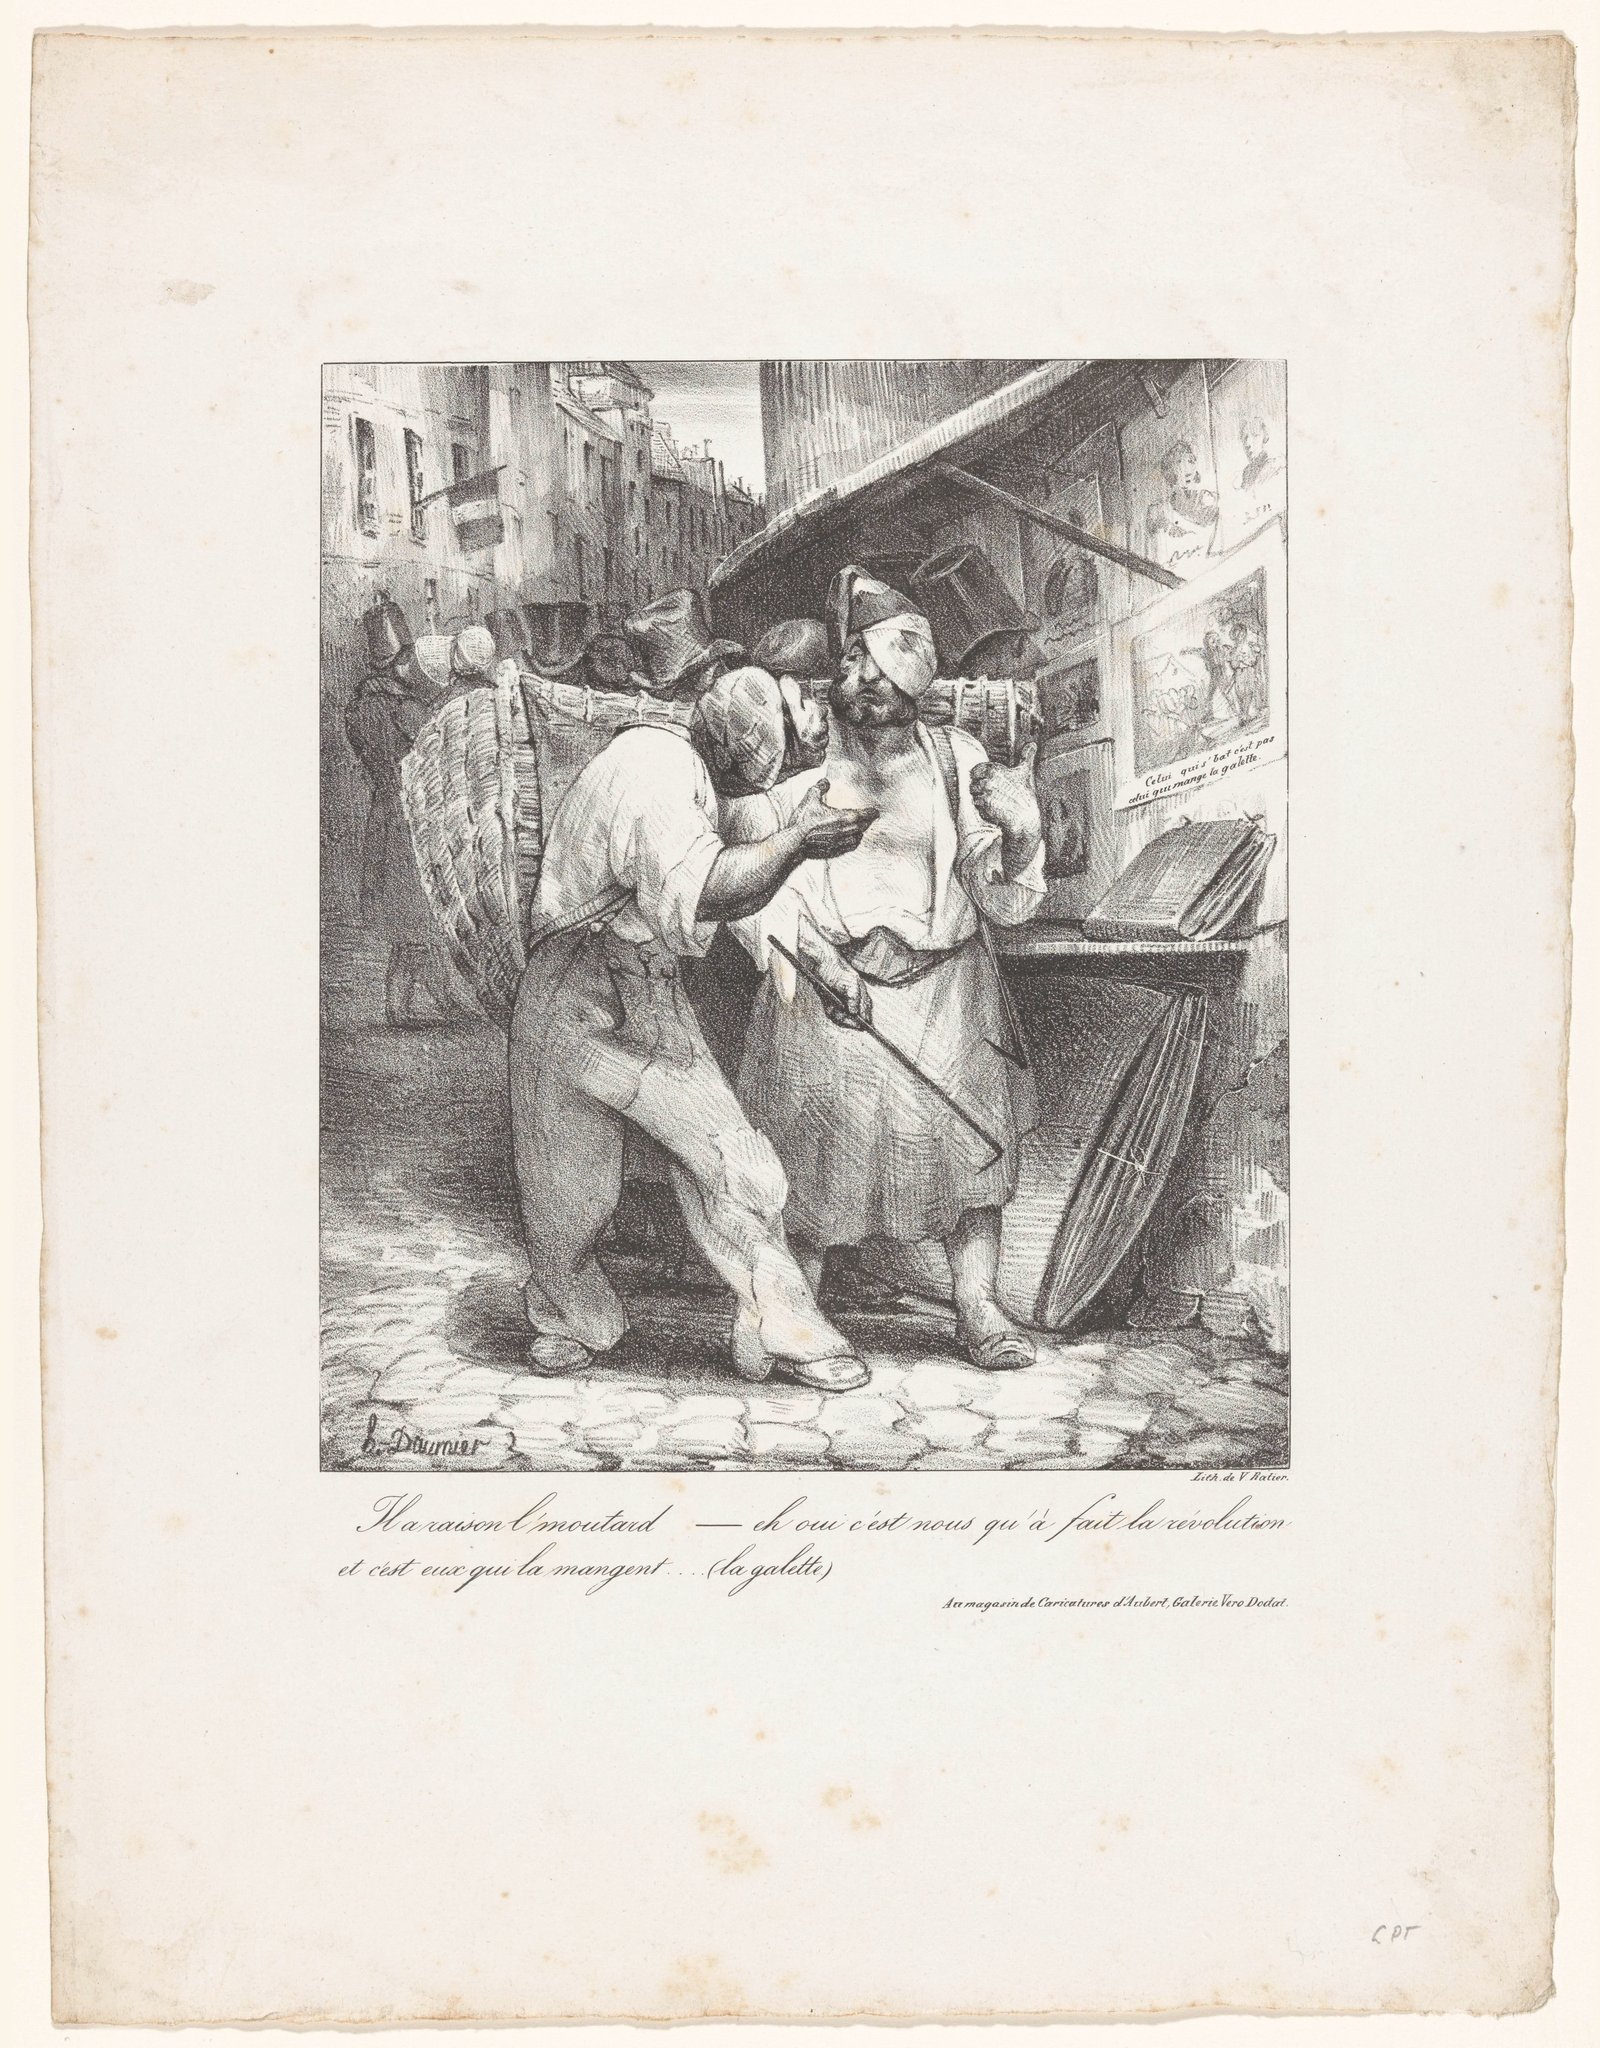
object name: print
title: Twee lompenhandelaren bespreken een prent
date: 1830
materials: paper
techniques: lithograph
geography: paris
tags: street-trader, city-view in general; 'veduta' (+ city(-scape) with figures, staffage)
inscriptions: collector's mark: Lugt 2228, collector's mark: Lugt 4779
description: Satire op de Franse Revolutie. De lompenhandelaren klagen dat degenen die de revolutie zijn begonnen niet profiteren van de uitkomst.